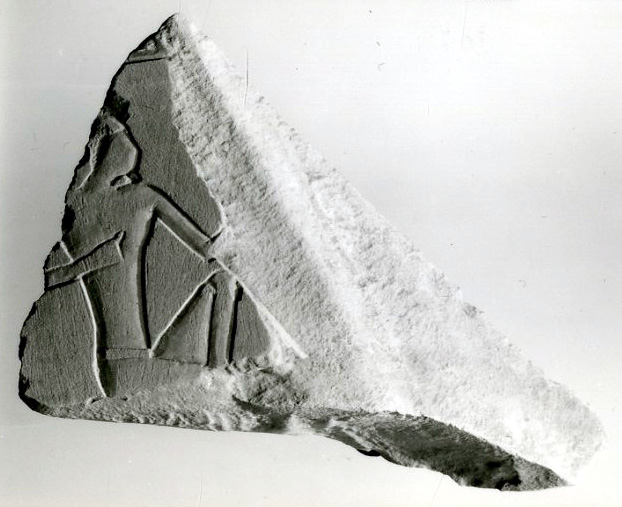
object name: relief fragment, tomb of meketre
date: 1981-1975 BCE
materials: limestone, paint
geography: egypt